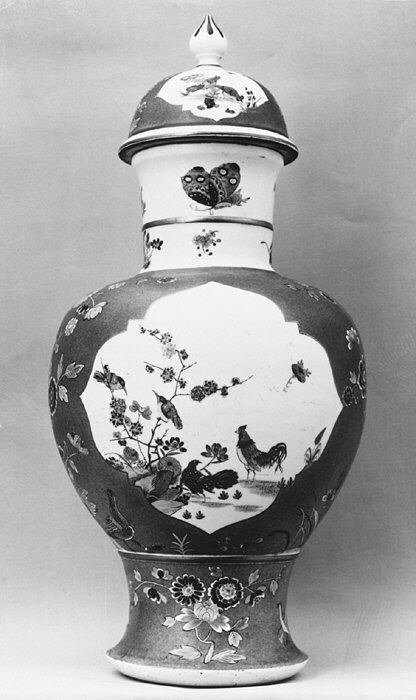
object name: vase with cover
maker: meissen manufactory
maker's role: manufactory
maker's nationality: german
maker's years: 1710-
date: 1730-1735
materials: hard paste porcelain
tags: birds,roosters,butterflies,flowers